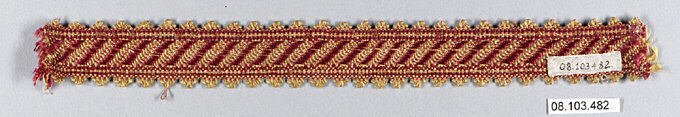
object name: galloon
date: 1801-1900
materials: silk